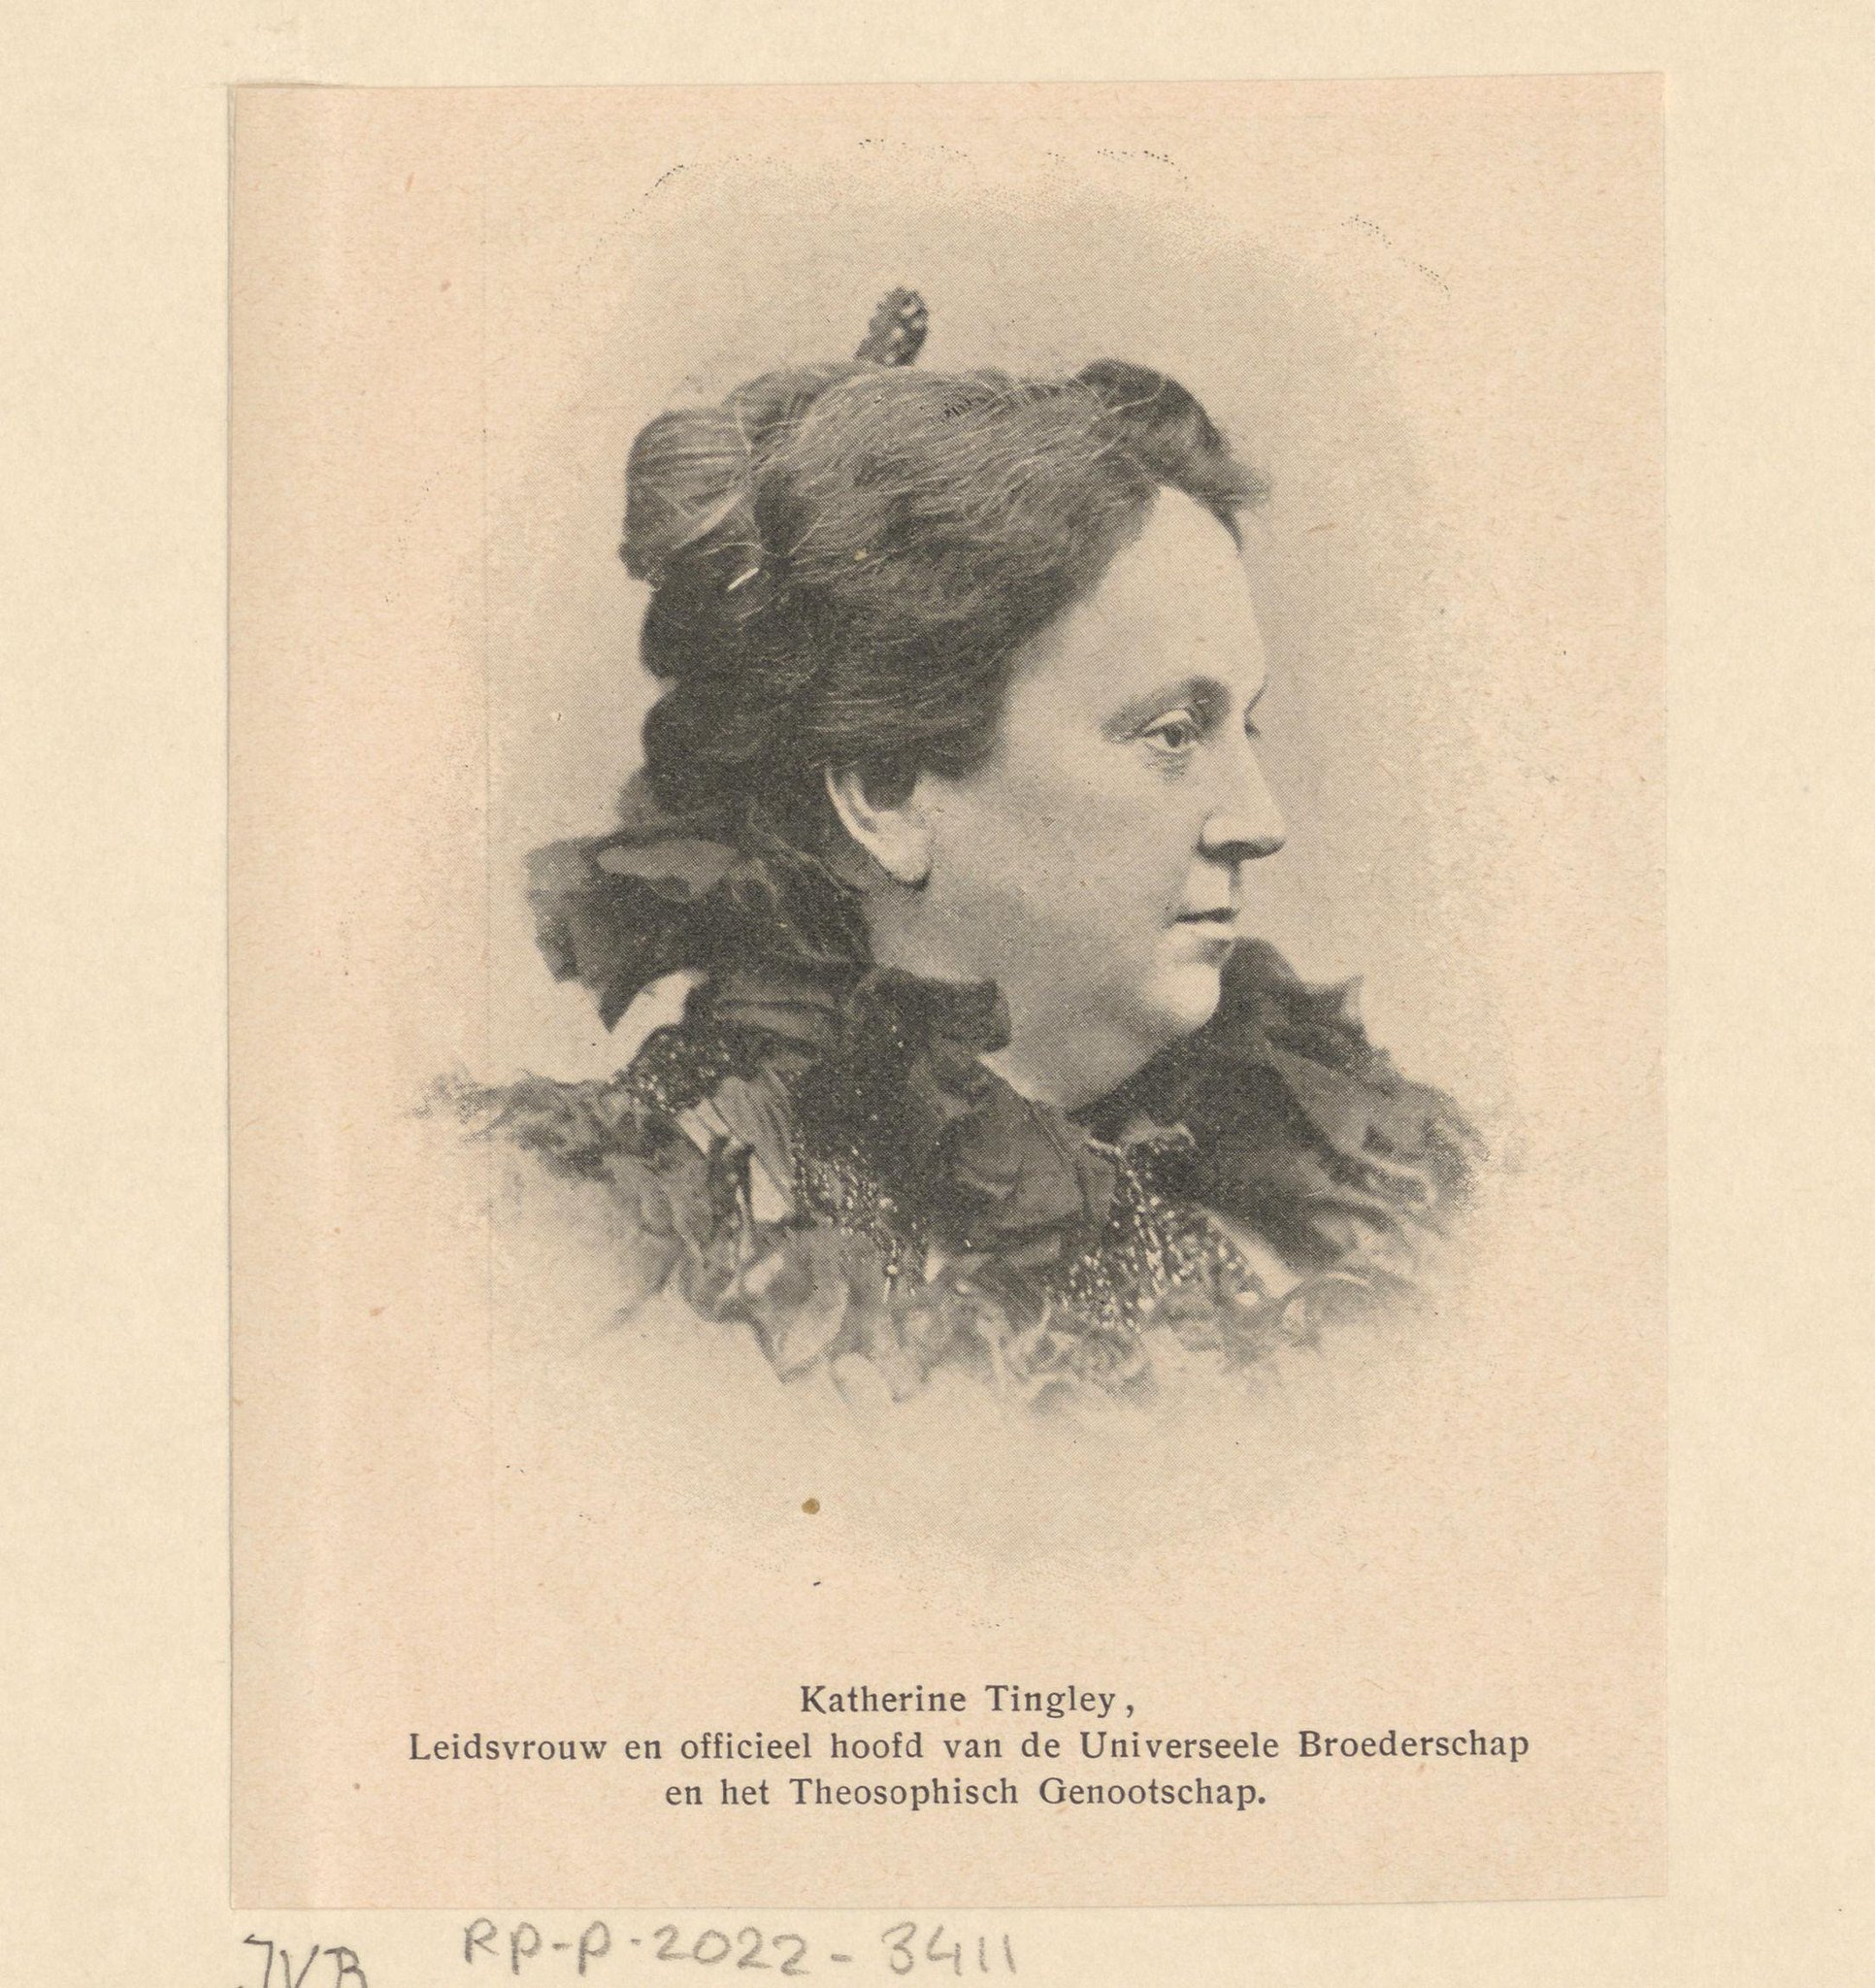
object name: photomechanical print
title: Portret van Katherine Tingley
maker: Anonymous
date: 1896-1929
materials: paper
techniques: autotype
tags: historical persons - bb - woman, miscellaneous religions, cults and doctrines: theosophy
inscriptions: collector's mark: ‘JVB’